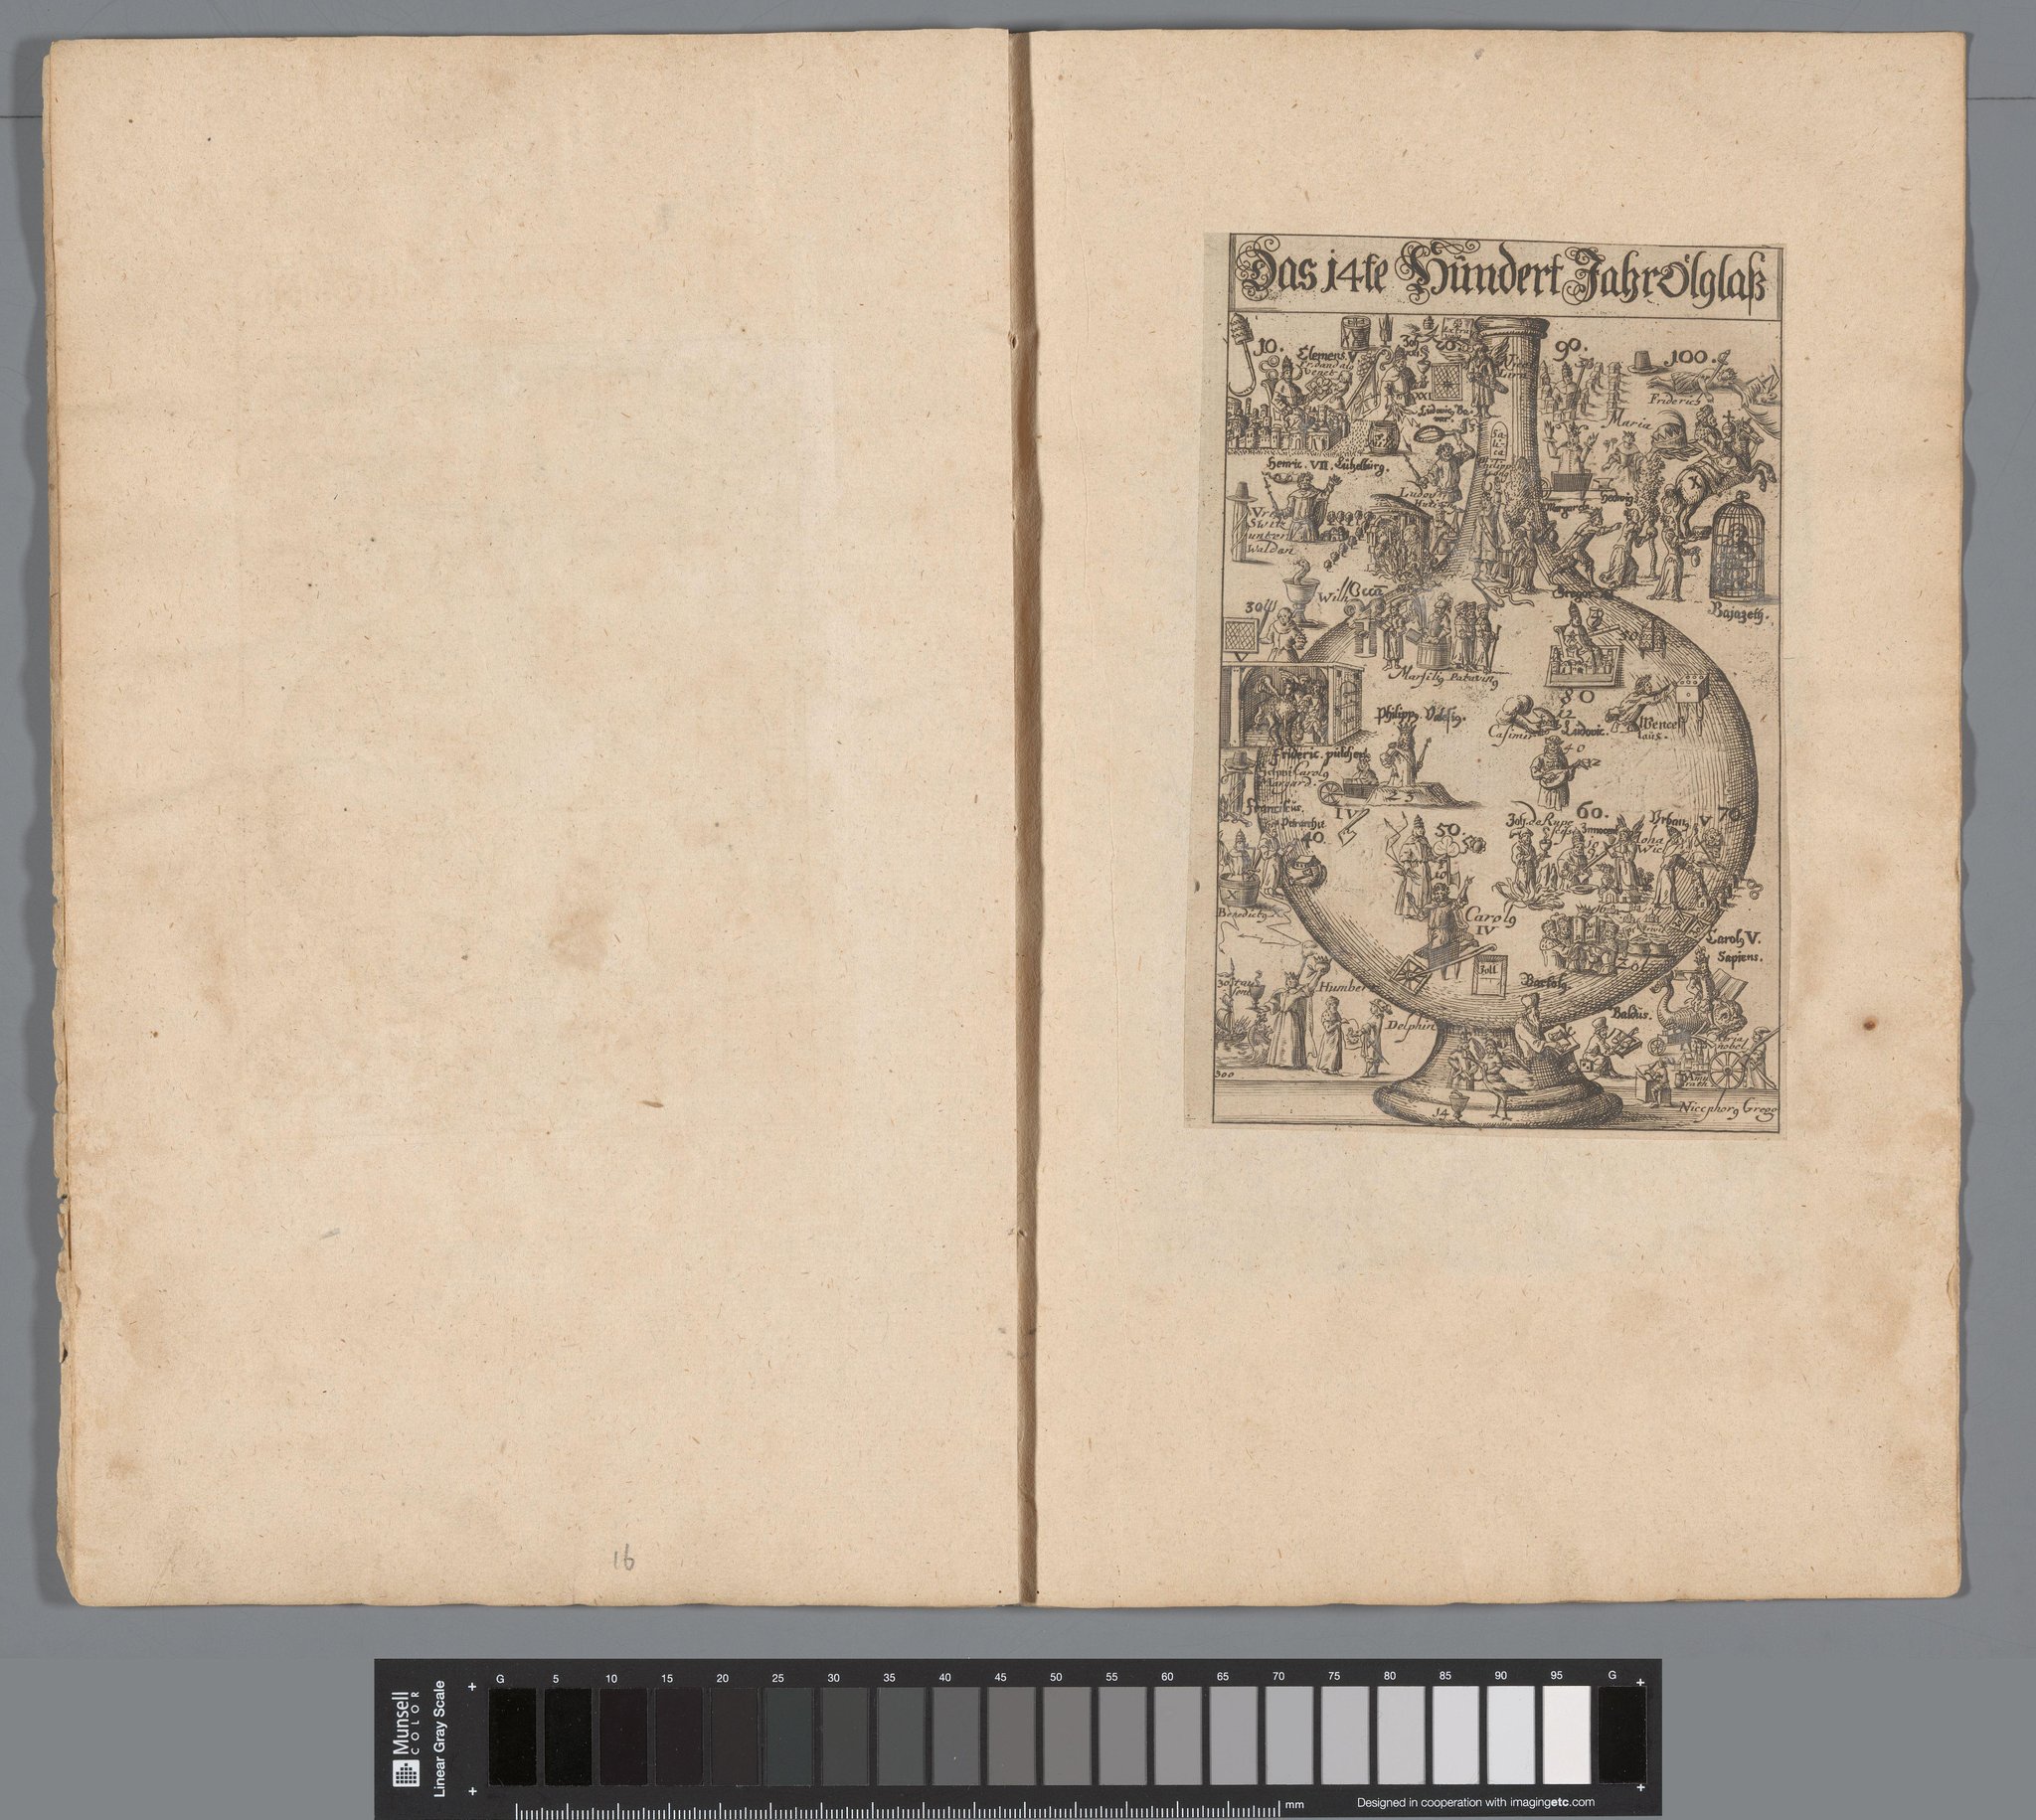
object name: print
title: Twaalfde eeuw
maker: Anonymous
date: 1667-1672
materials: paper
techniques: engraving, etching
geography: germany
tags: city-walls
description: Prenten afkomstig uit een editie van: Johannes Buno, Historische Bilder/ Darinnen Idea Historiae Universalis : Eine kurtze Summarische Abbildung Der fürnehmsten Geist- und Weltlichen Geschichte durch die vier Monarchien ..., eerst uitgegeven door Bartold Elers in Lüneburg in 1672.